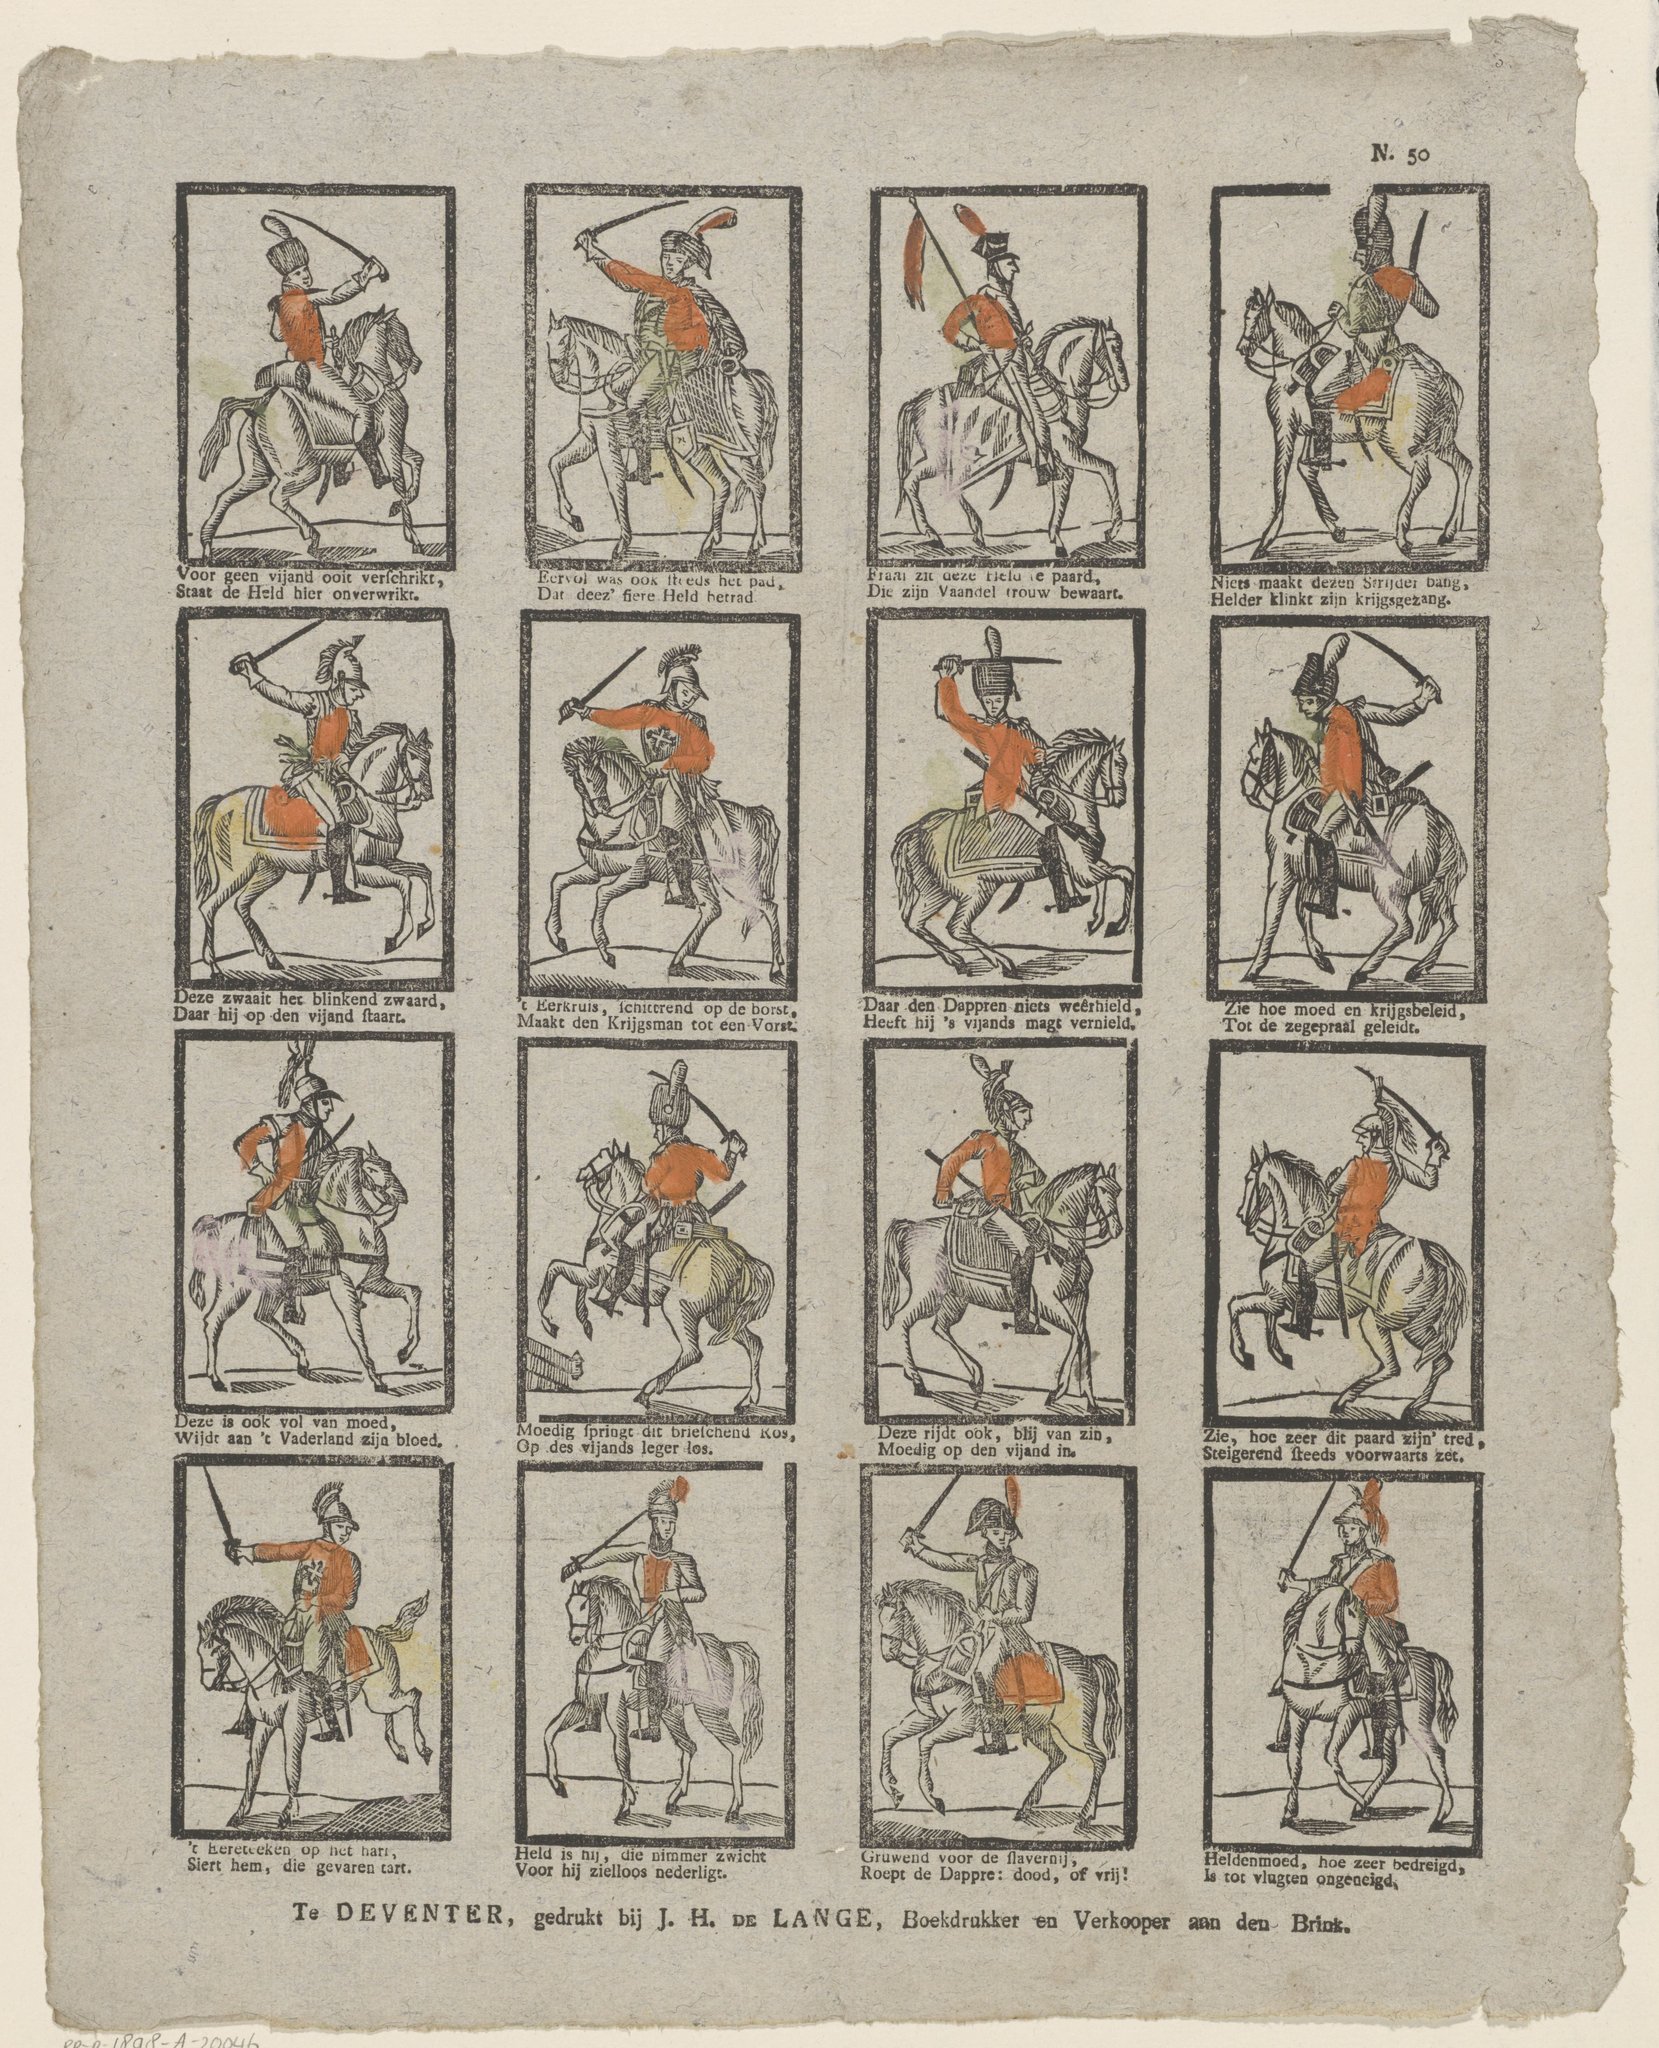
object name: print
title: Militairen te paard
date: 1787-1822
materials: paper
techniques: colour, letterpress printing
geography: netherlands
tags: warfare; military affairs (+ cavalry, horsemen), the soldier; the soldier's life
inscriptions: collector's mark: Lugt 2166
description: Blad met 16 voorstellingen van militairen te paard. Onder elke afbeelding een tweeregelig vers. Genummerd rechtsboven: N. 50.